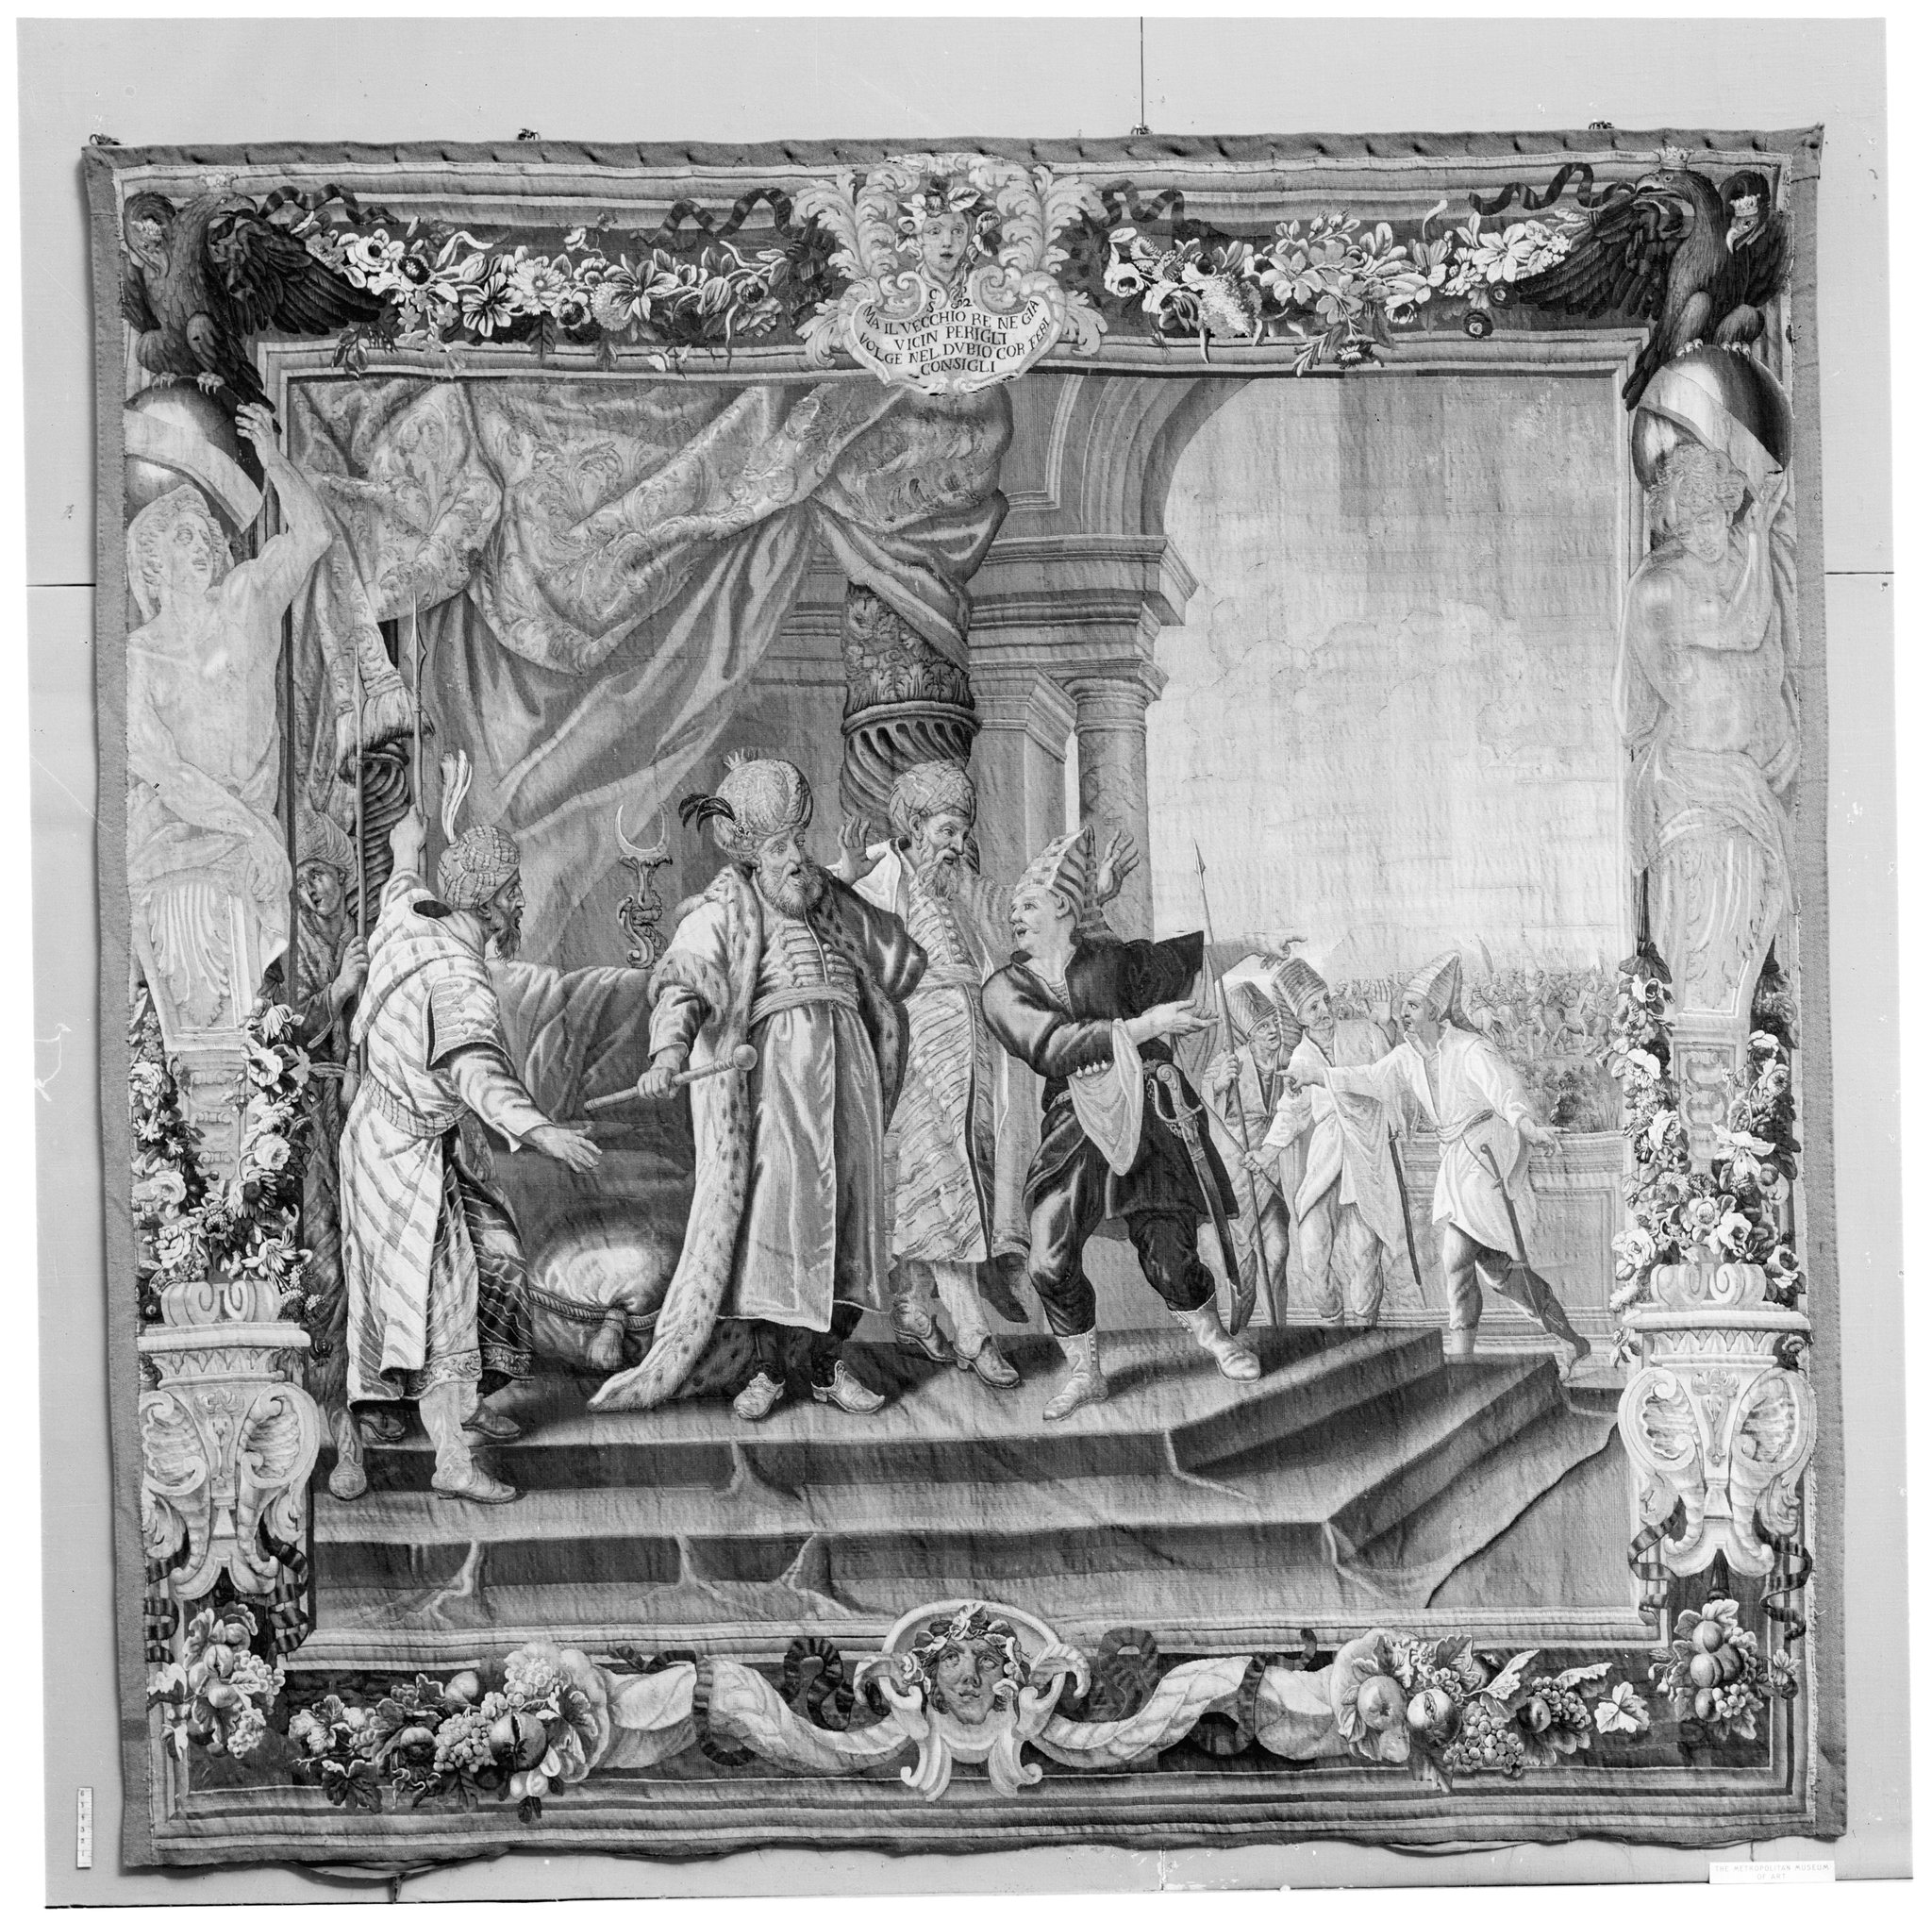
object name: tapestry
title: Aladin Hears of the Crusaders' Approach (from a set of Scenes from Gerusalemme Liberata)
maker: domenico paradisi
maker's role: designer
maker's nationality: italian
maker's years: 1689-1721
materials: silk, wool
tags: palaces,soldiers,kings,men